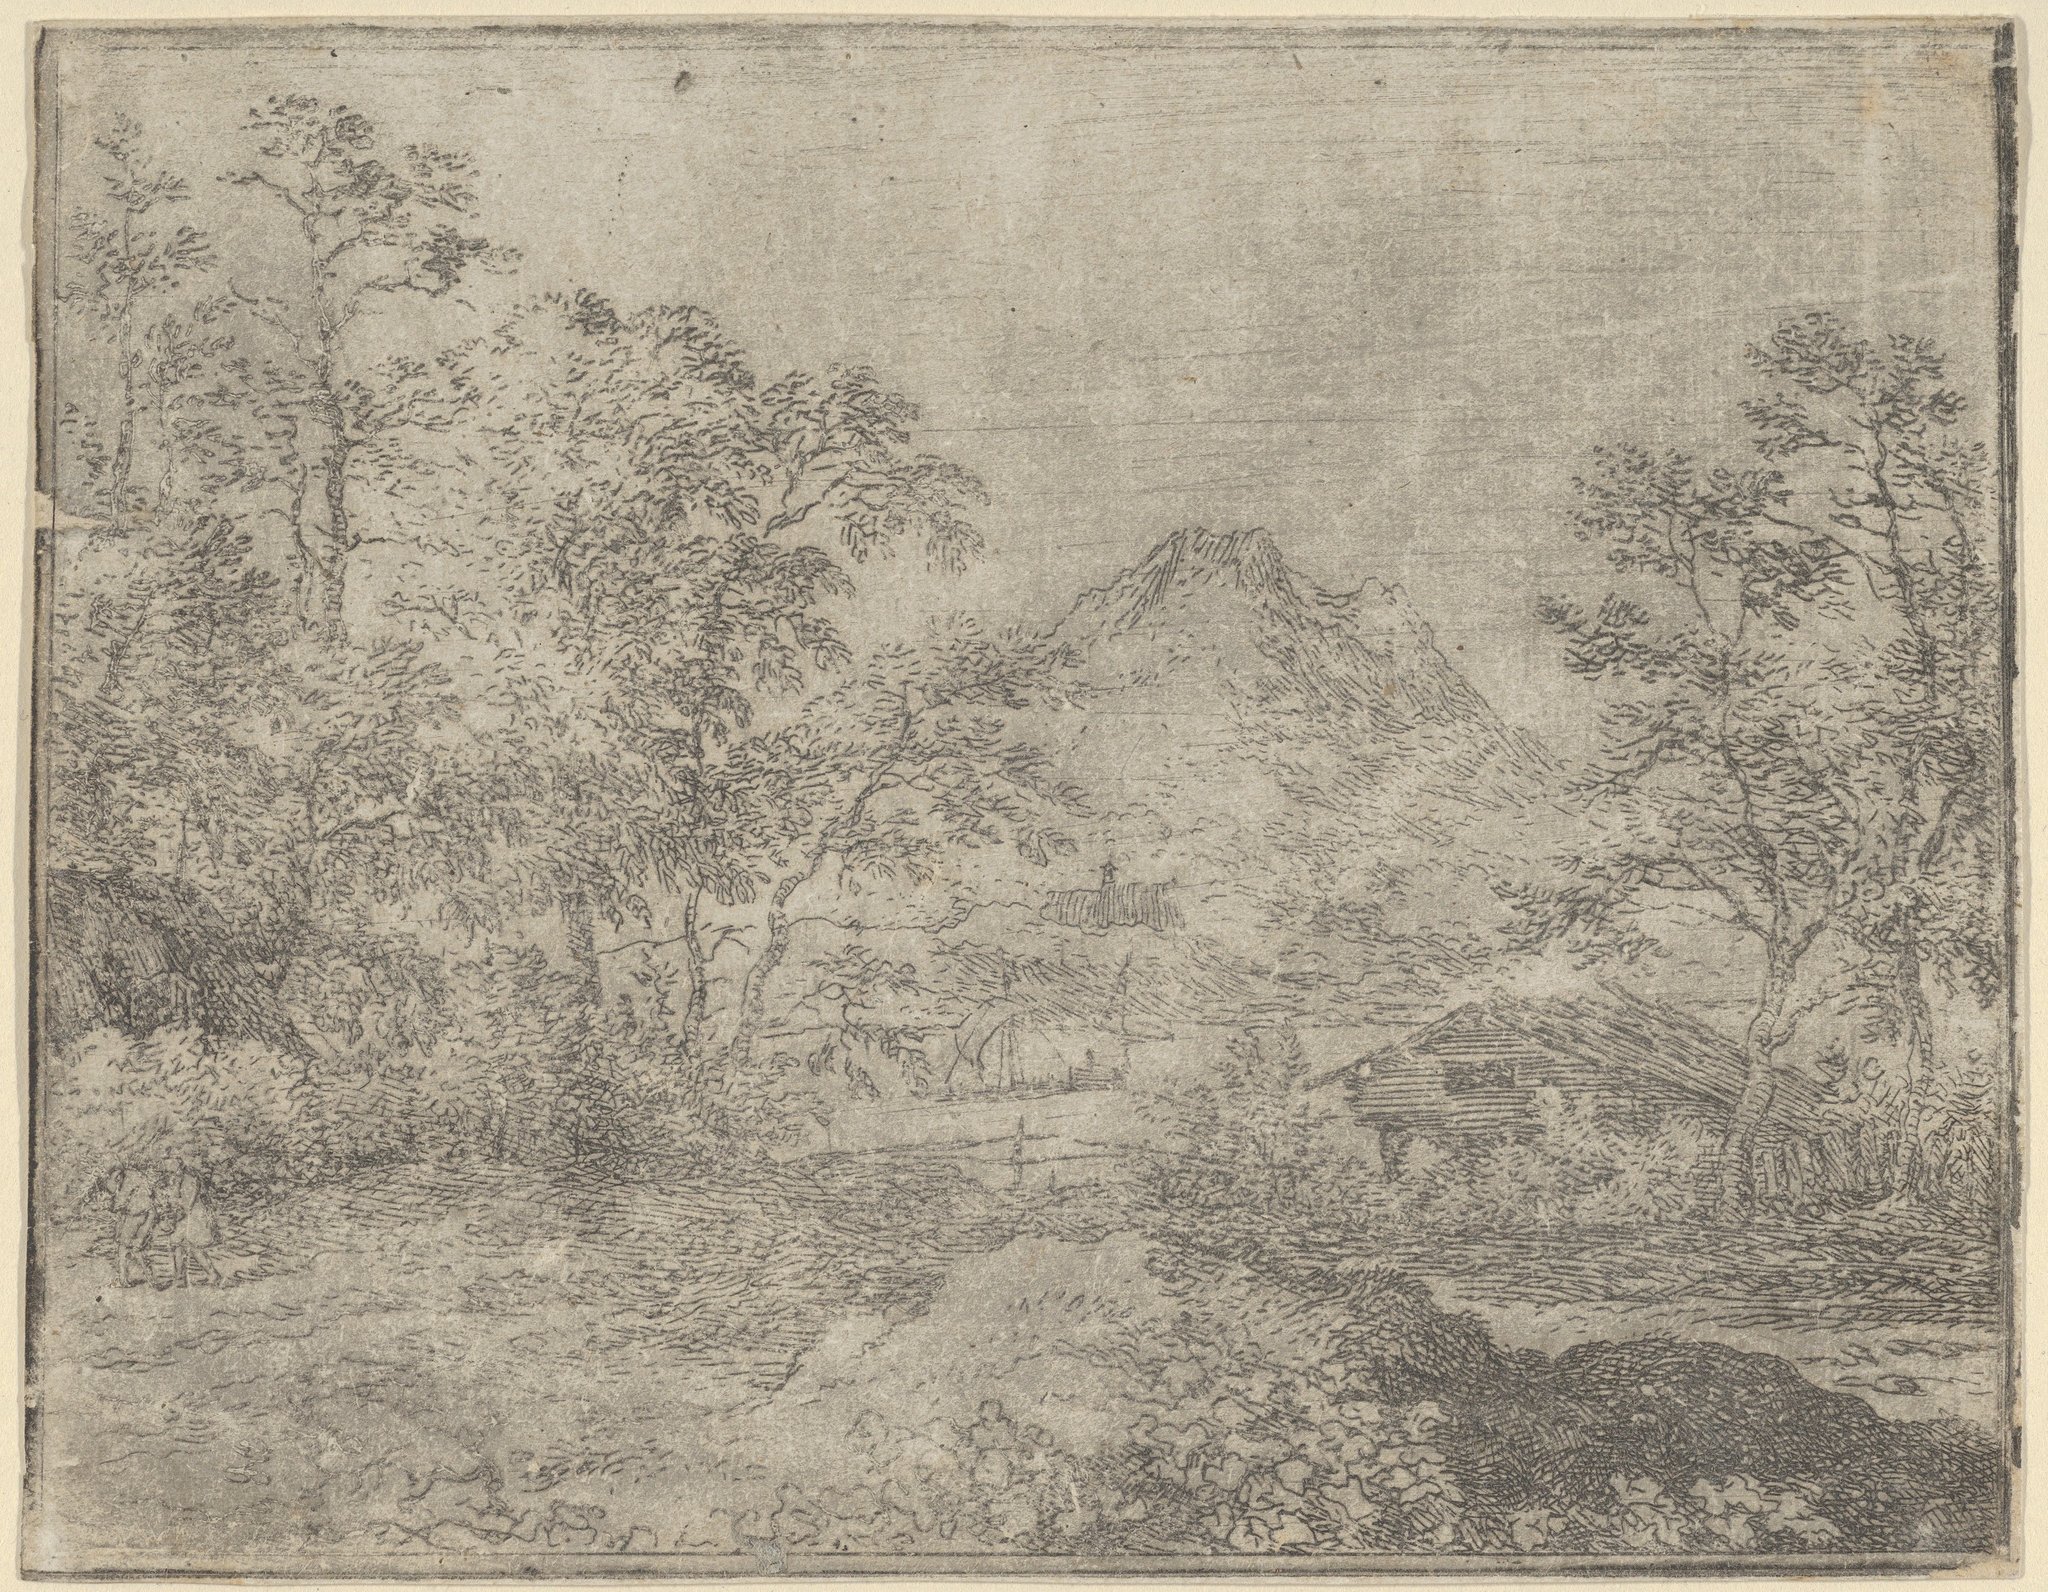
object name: print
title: The Broad River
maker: allart van everdingen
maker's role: artist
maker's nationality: dutch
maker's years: 1621-1675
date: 1621-1675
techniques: engraving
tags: rivers,landscapes,trees